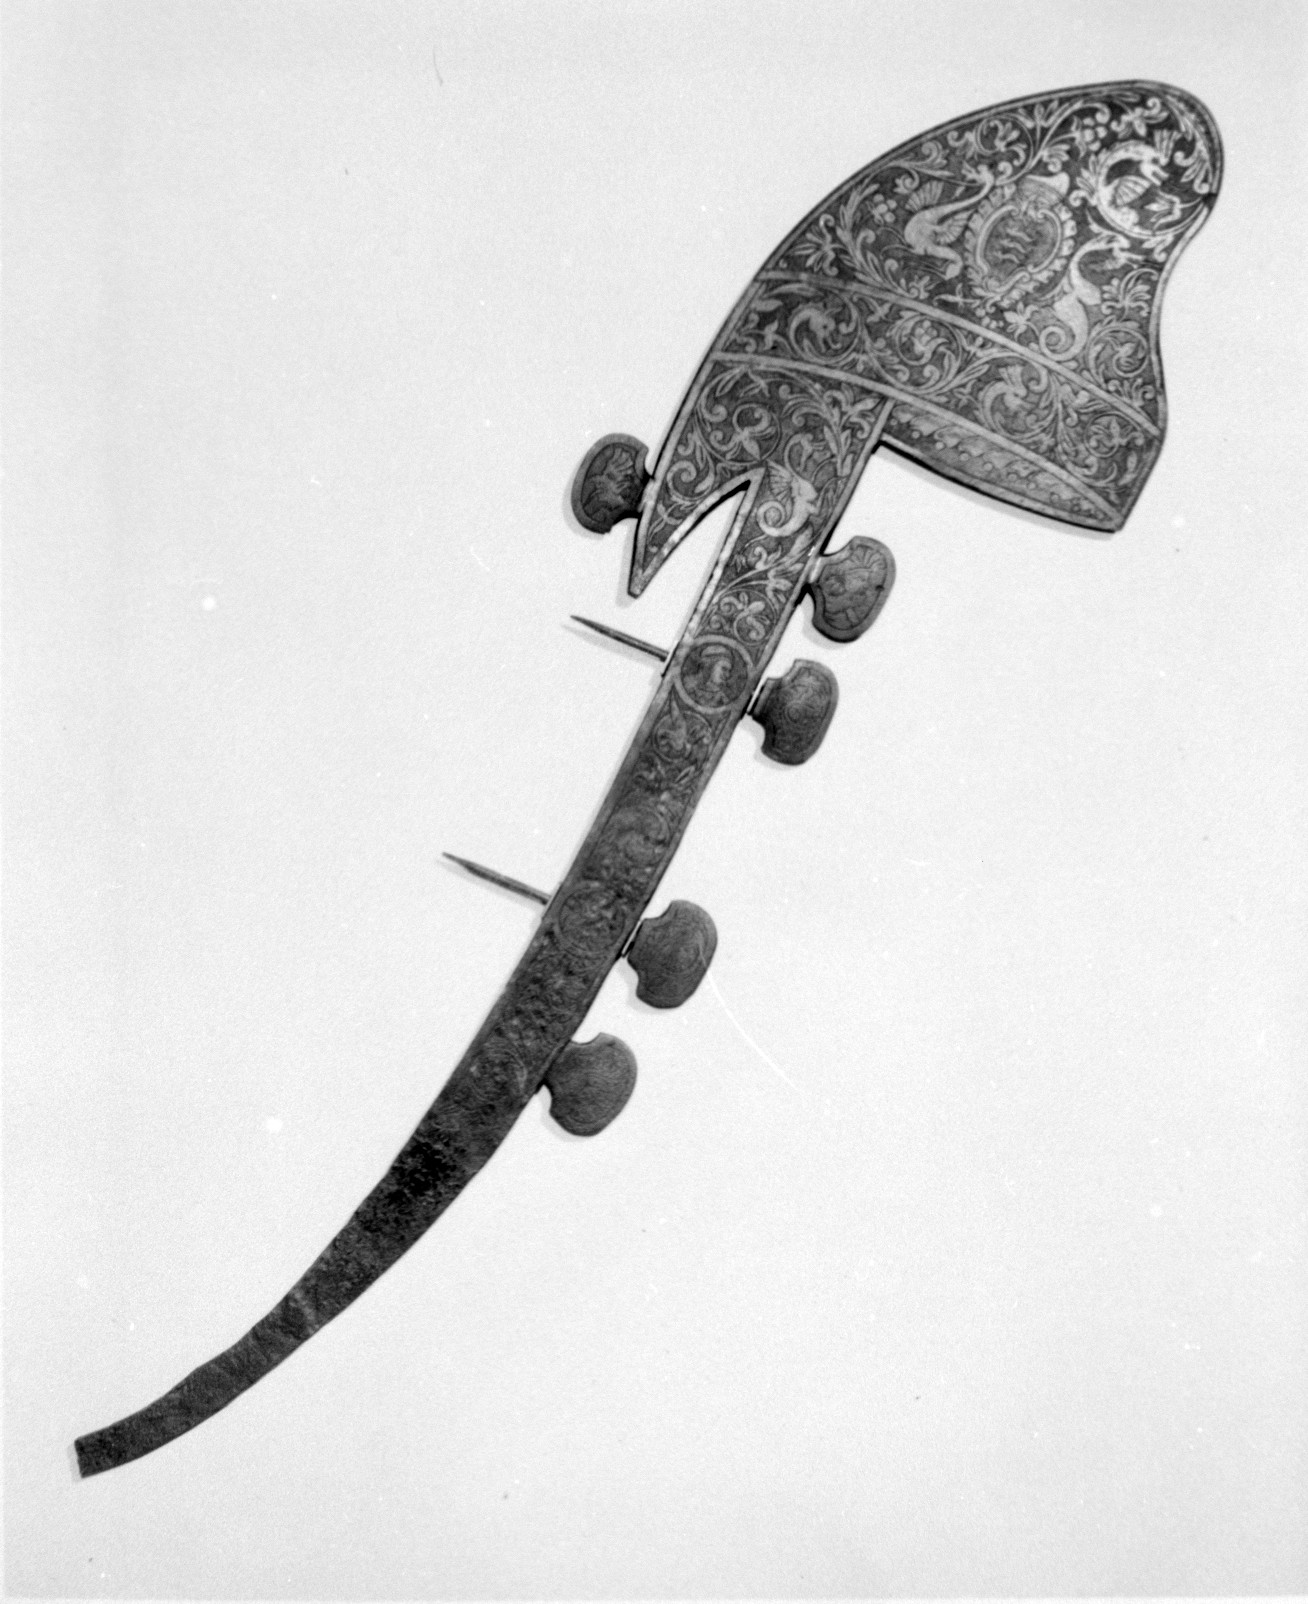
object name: gondola prow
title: Gondola prow in the shape of a doge's cap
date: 1701-1800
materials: iron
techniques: gilding